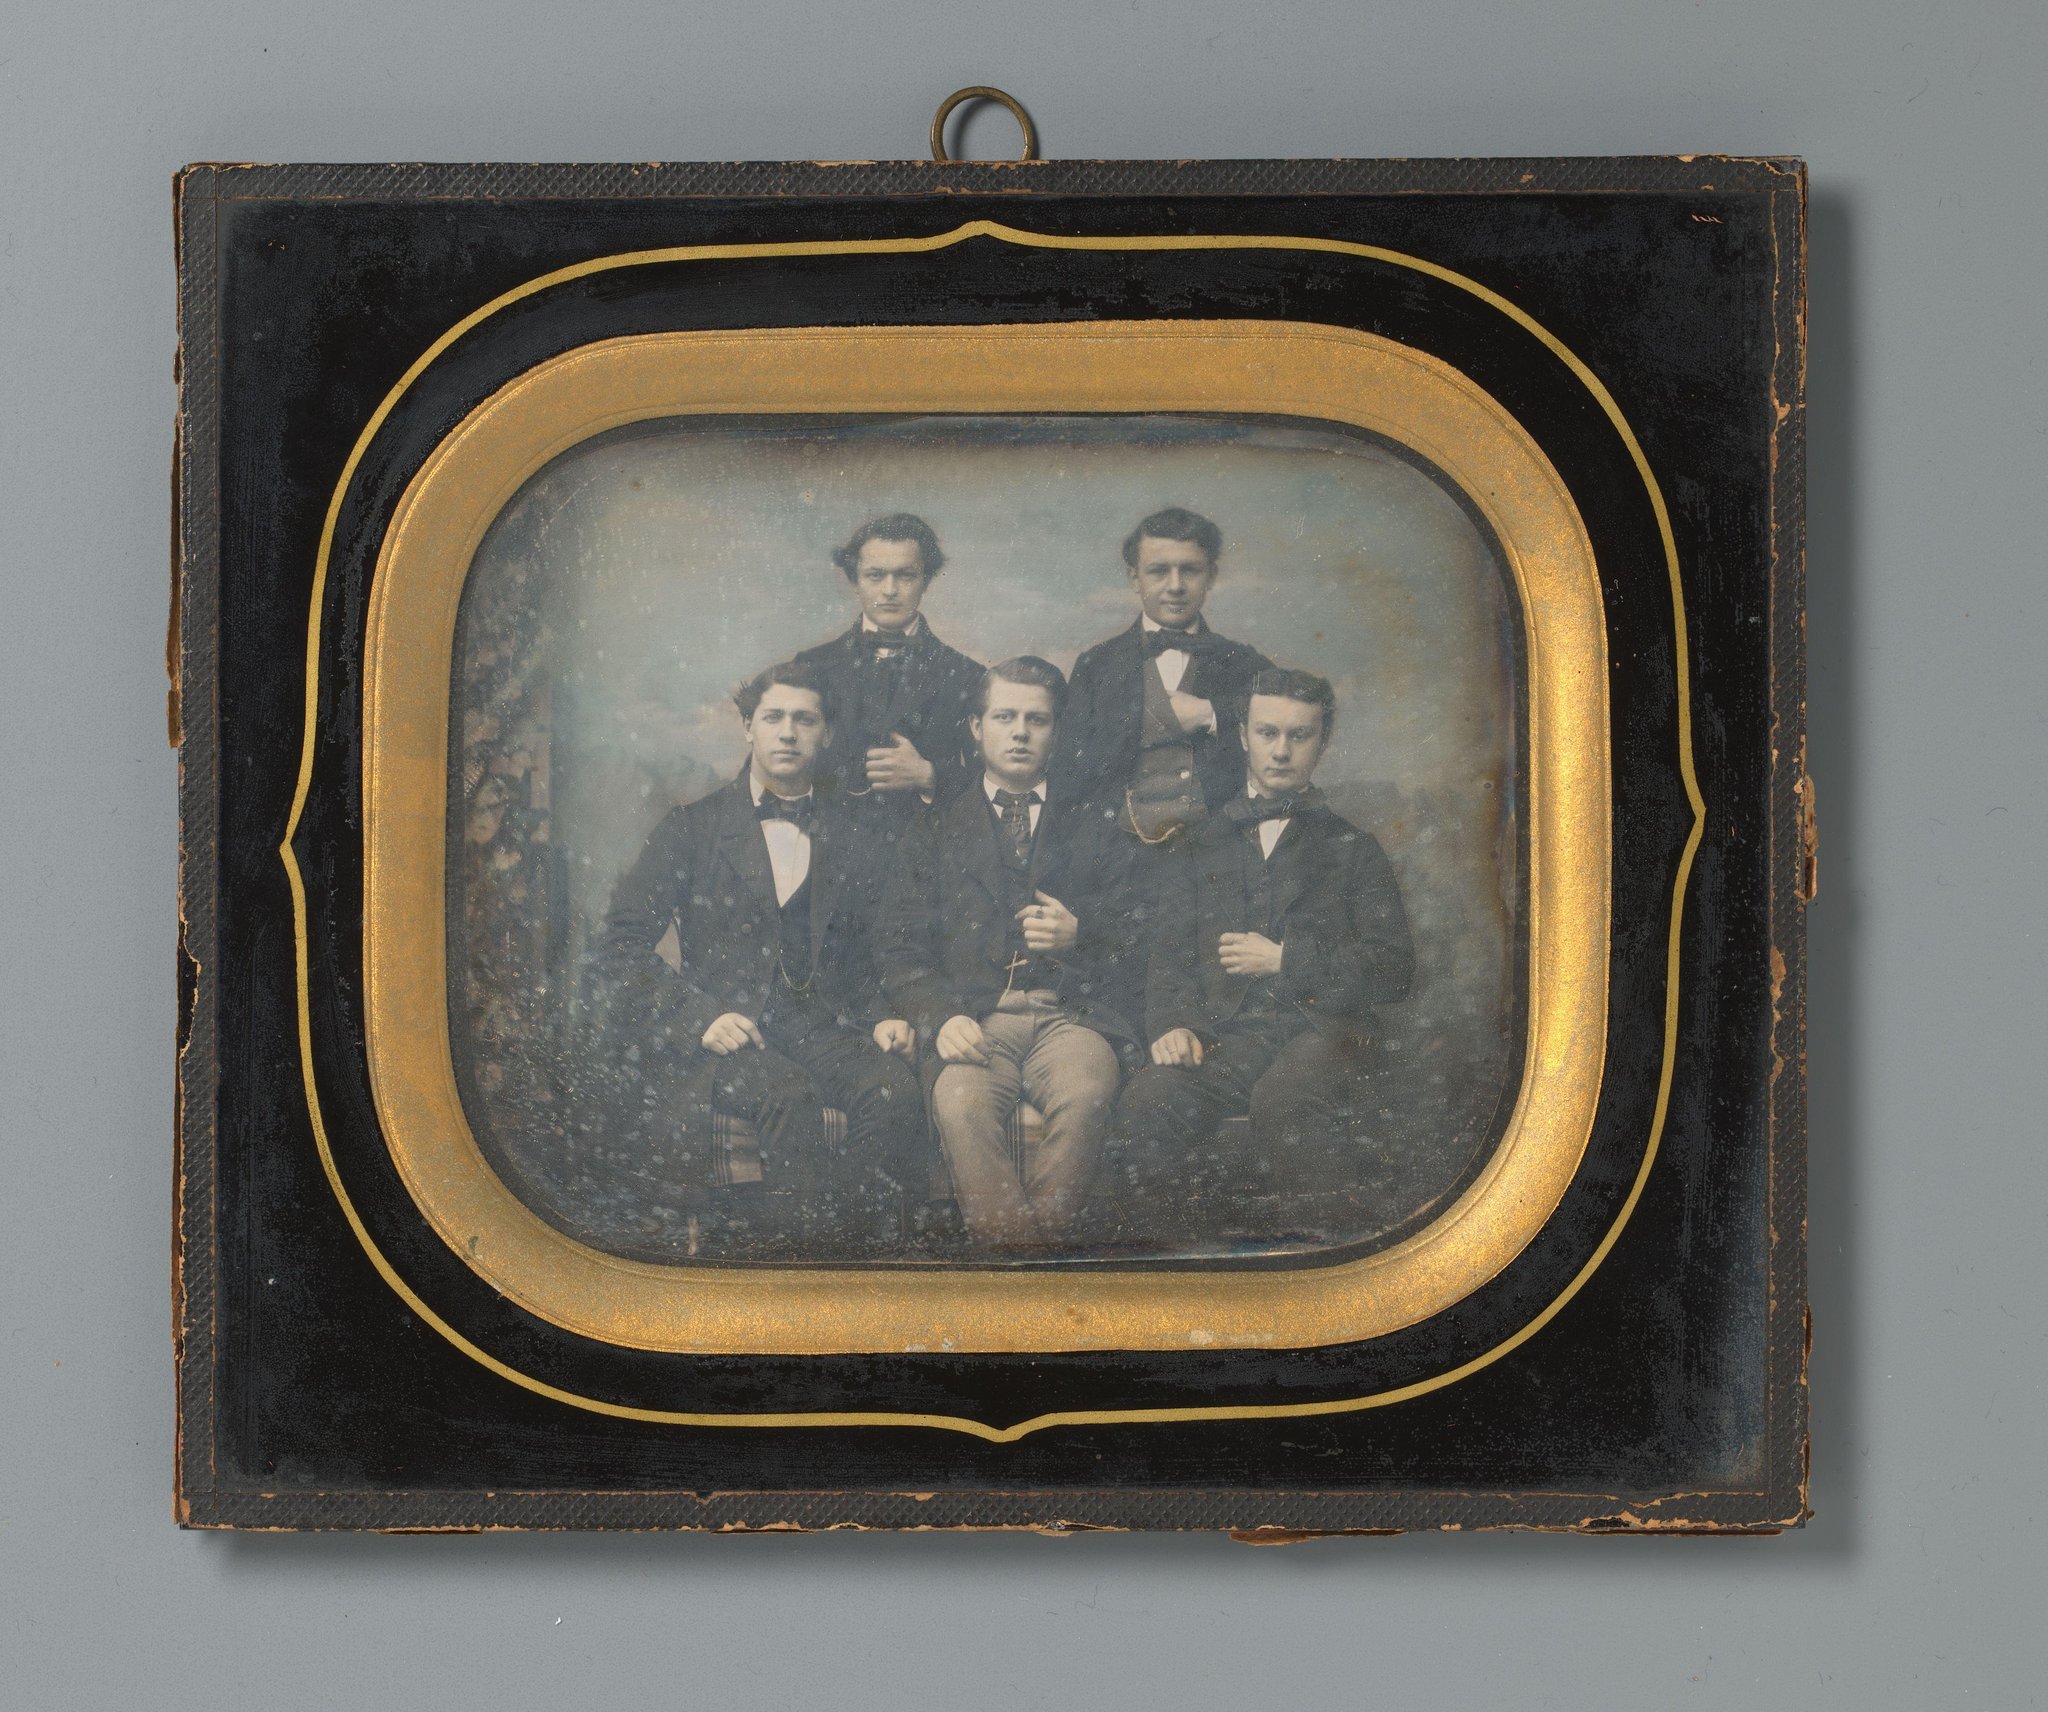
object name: photograph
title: Portret van vijf onbekende jonge mannen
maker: Anonymous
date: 1840-1860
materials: copper, glass, paper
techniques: daguerreotype, hand coloring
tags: youth, adolescent, anonymous historical persons portrayed in a group, in a group-portrait